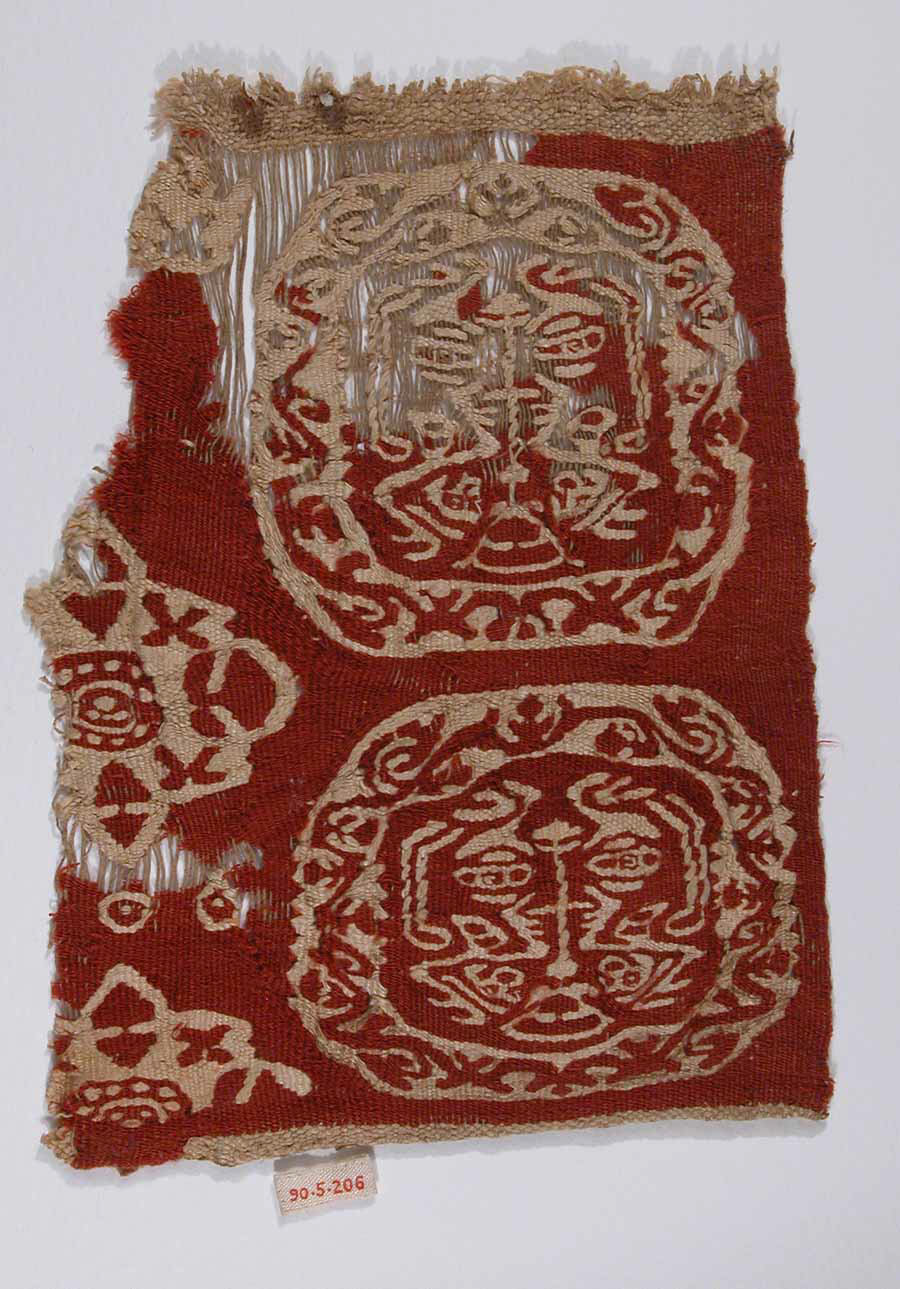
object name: textile fragment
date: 501-700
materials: linen, wool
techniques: weave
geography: egypt